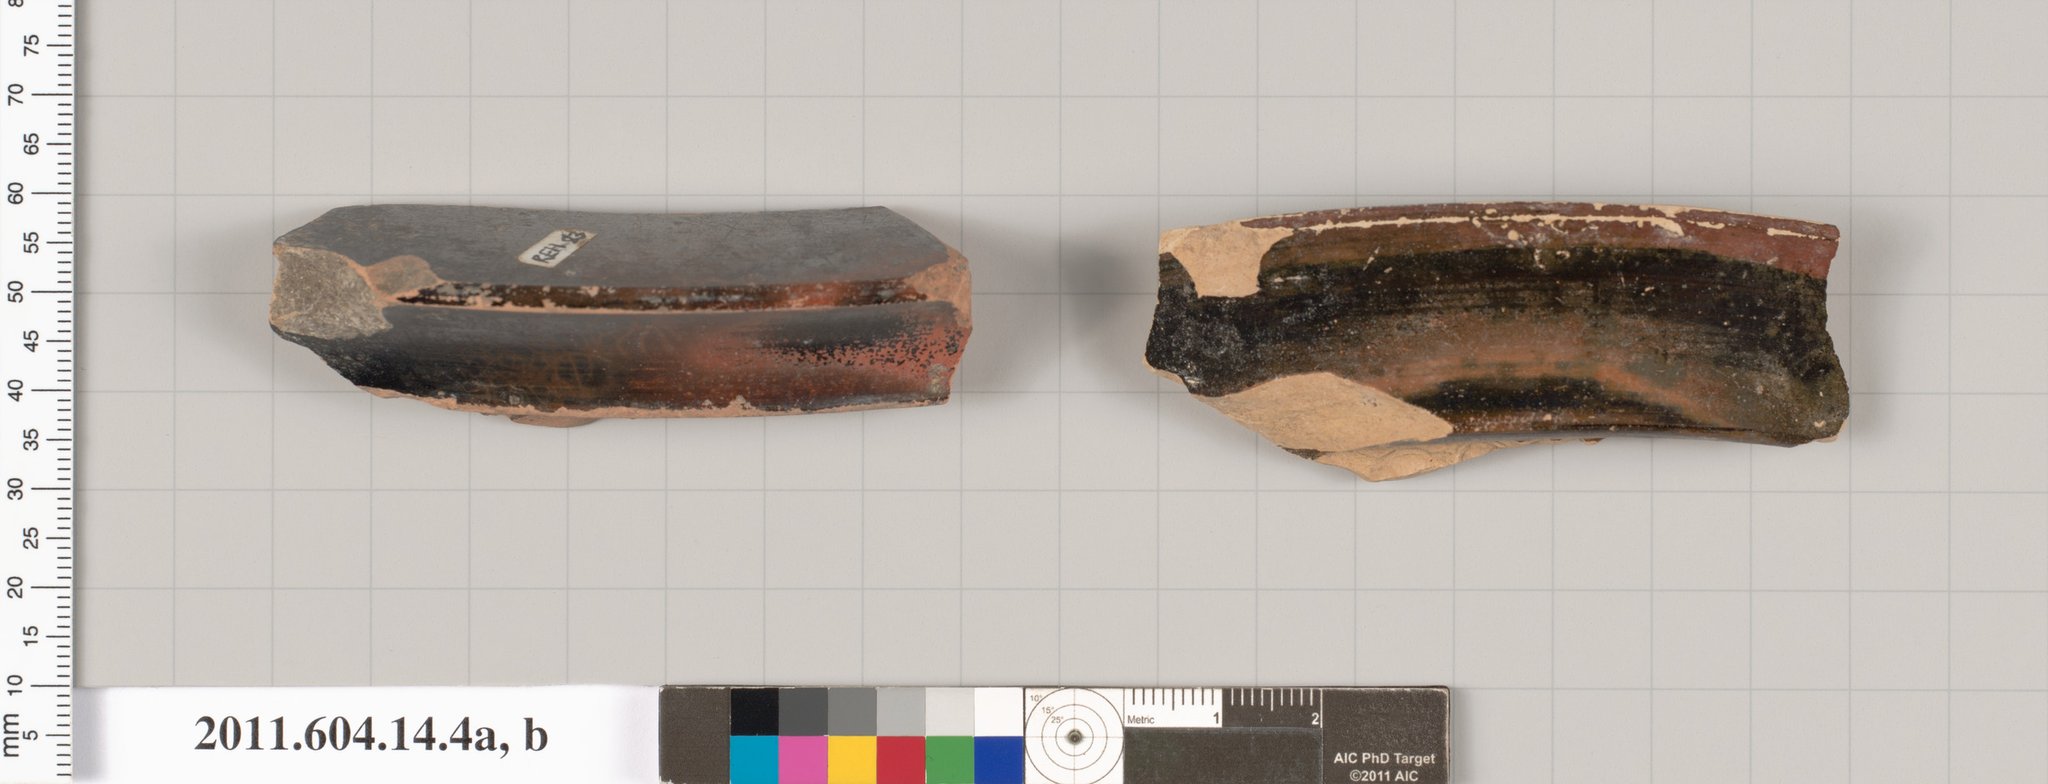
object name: amphora fragment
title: Terracotta fragments of an amphorae (jars)?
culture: unknown fabric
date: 600-501 BCE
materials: terracotta